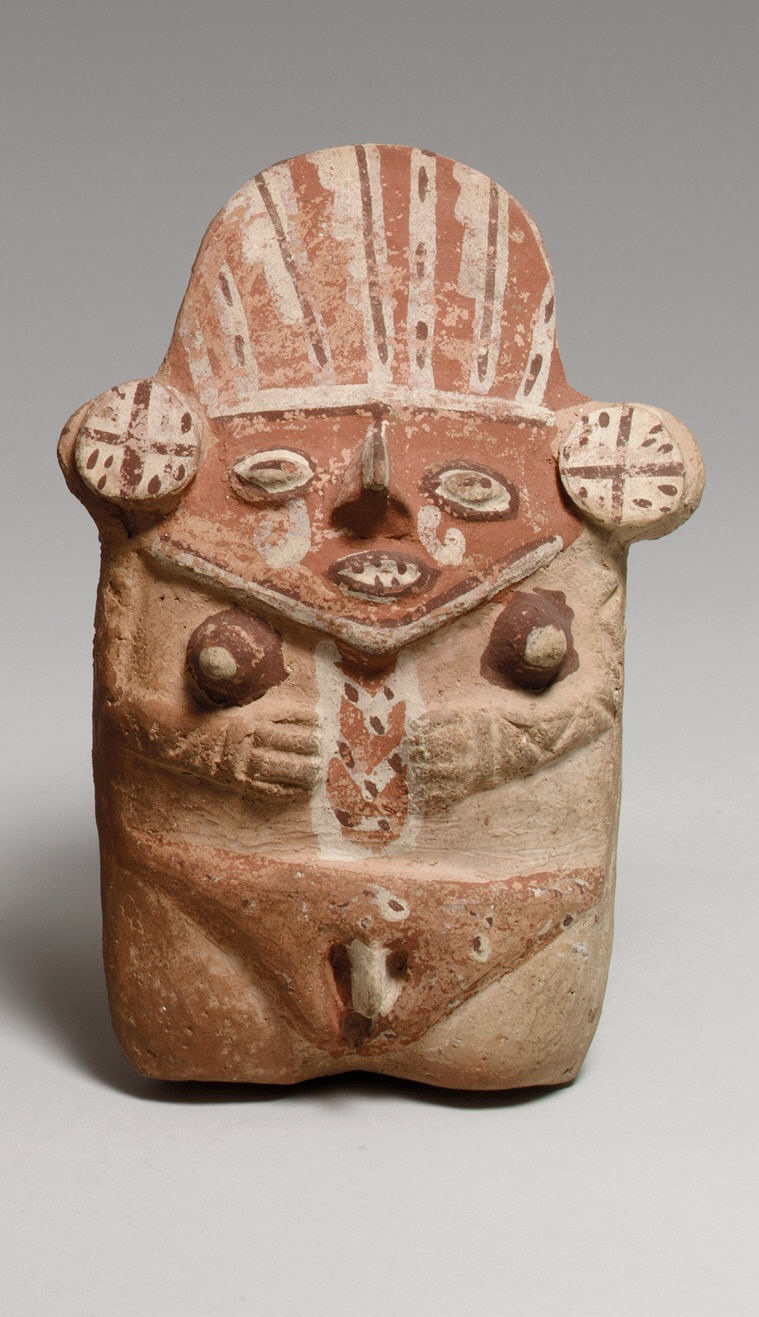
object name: figure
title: Female Figure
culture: chancay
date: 1101-1400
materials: ceramic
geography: peru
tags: women